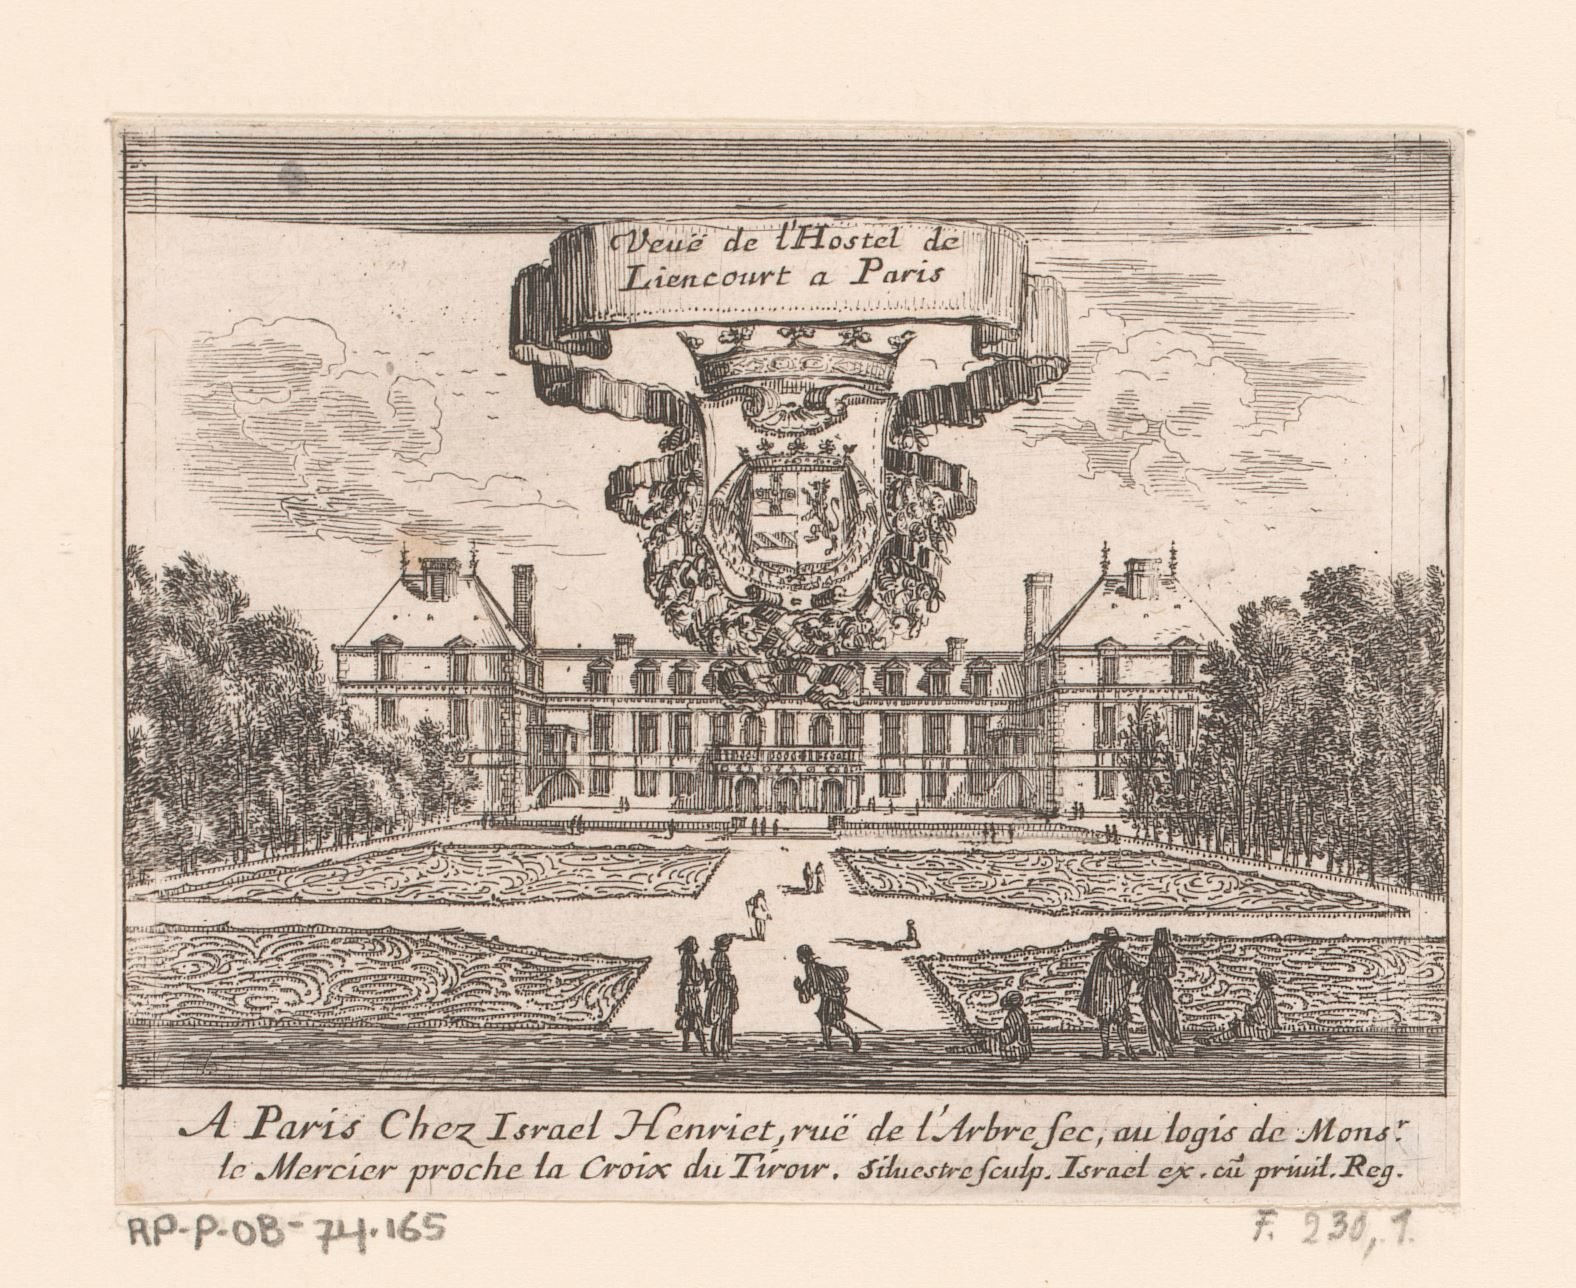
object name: titelprent, frontispice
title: Gezichten op het kasteel van Rochefoucauld in Liancourt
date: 1631-1661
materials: paper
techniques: etching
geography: paris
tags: french or architectonic garden; formal garden, landscape with tower or castle (+ city(-scape) with figures, staffage), paris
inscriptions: collector's mark: Lugt 240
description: Prent maakt deel uit van een ongenummerde serie van negen prenten.